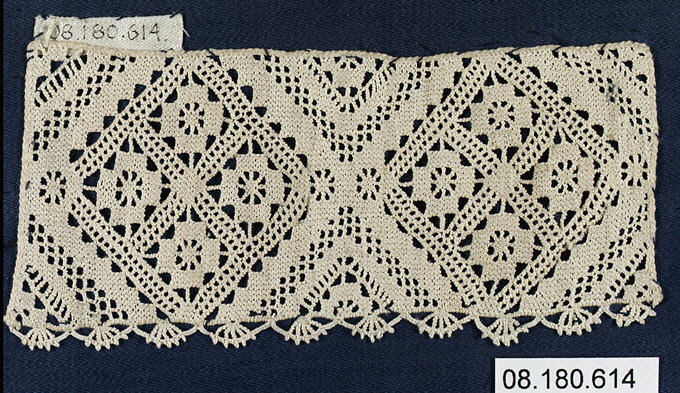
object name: fragment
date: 1801-1900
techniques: lace